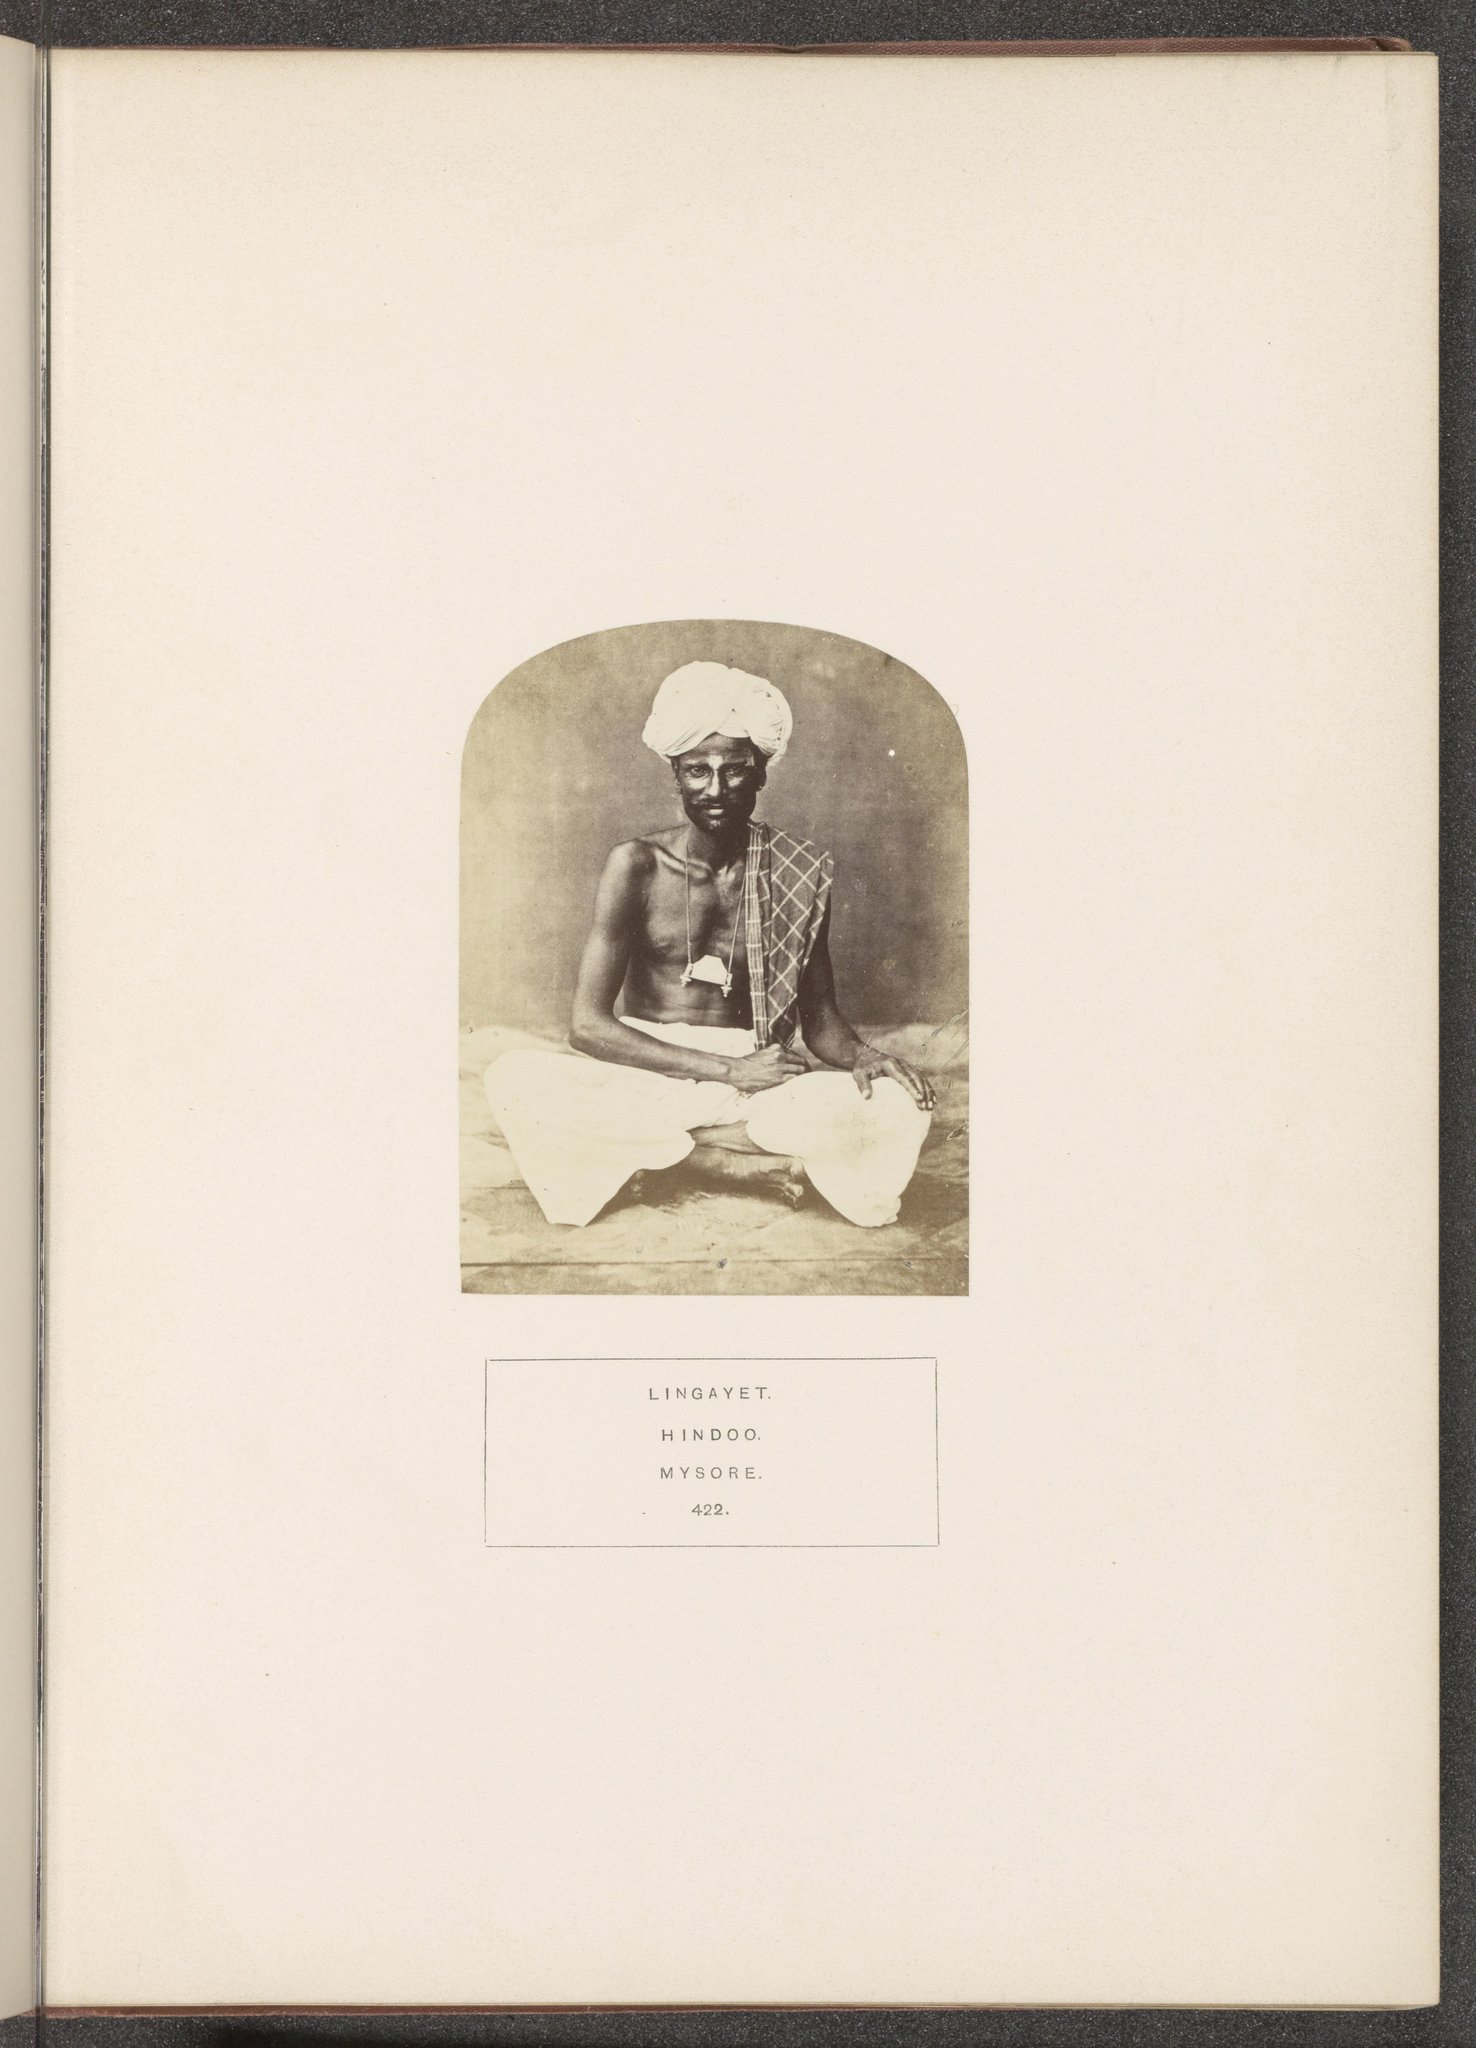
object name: photograph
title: Portrait of an unknown man from the Lingayat community of Mysore, Karnataka, India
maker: Anonymous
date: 1865-1875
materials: photographic support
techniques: albumen print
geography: mysore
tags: human races; peoples; nationalities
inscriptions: inscription: ‘LINGAYET./ HINDOO./ MYSORE.’, number: ‘422.’